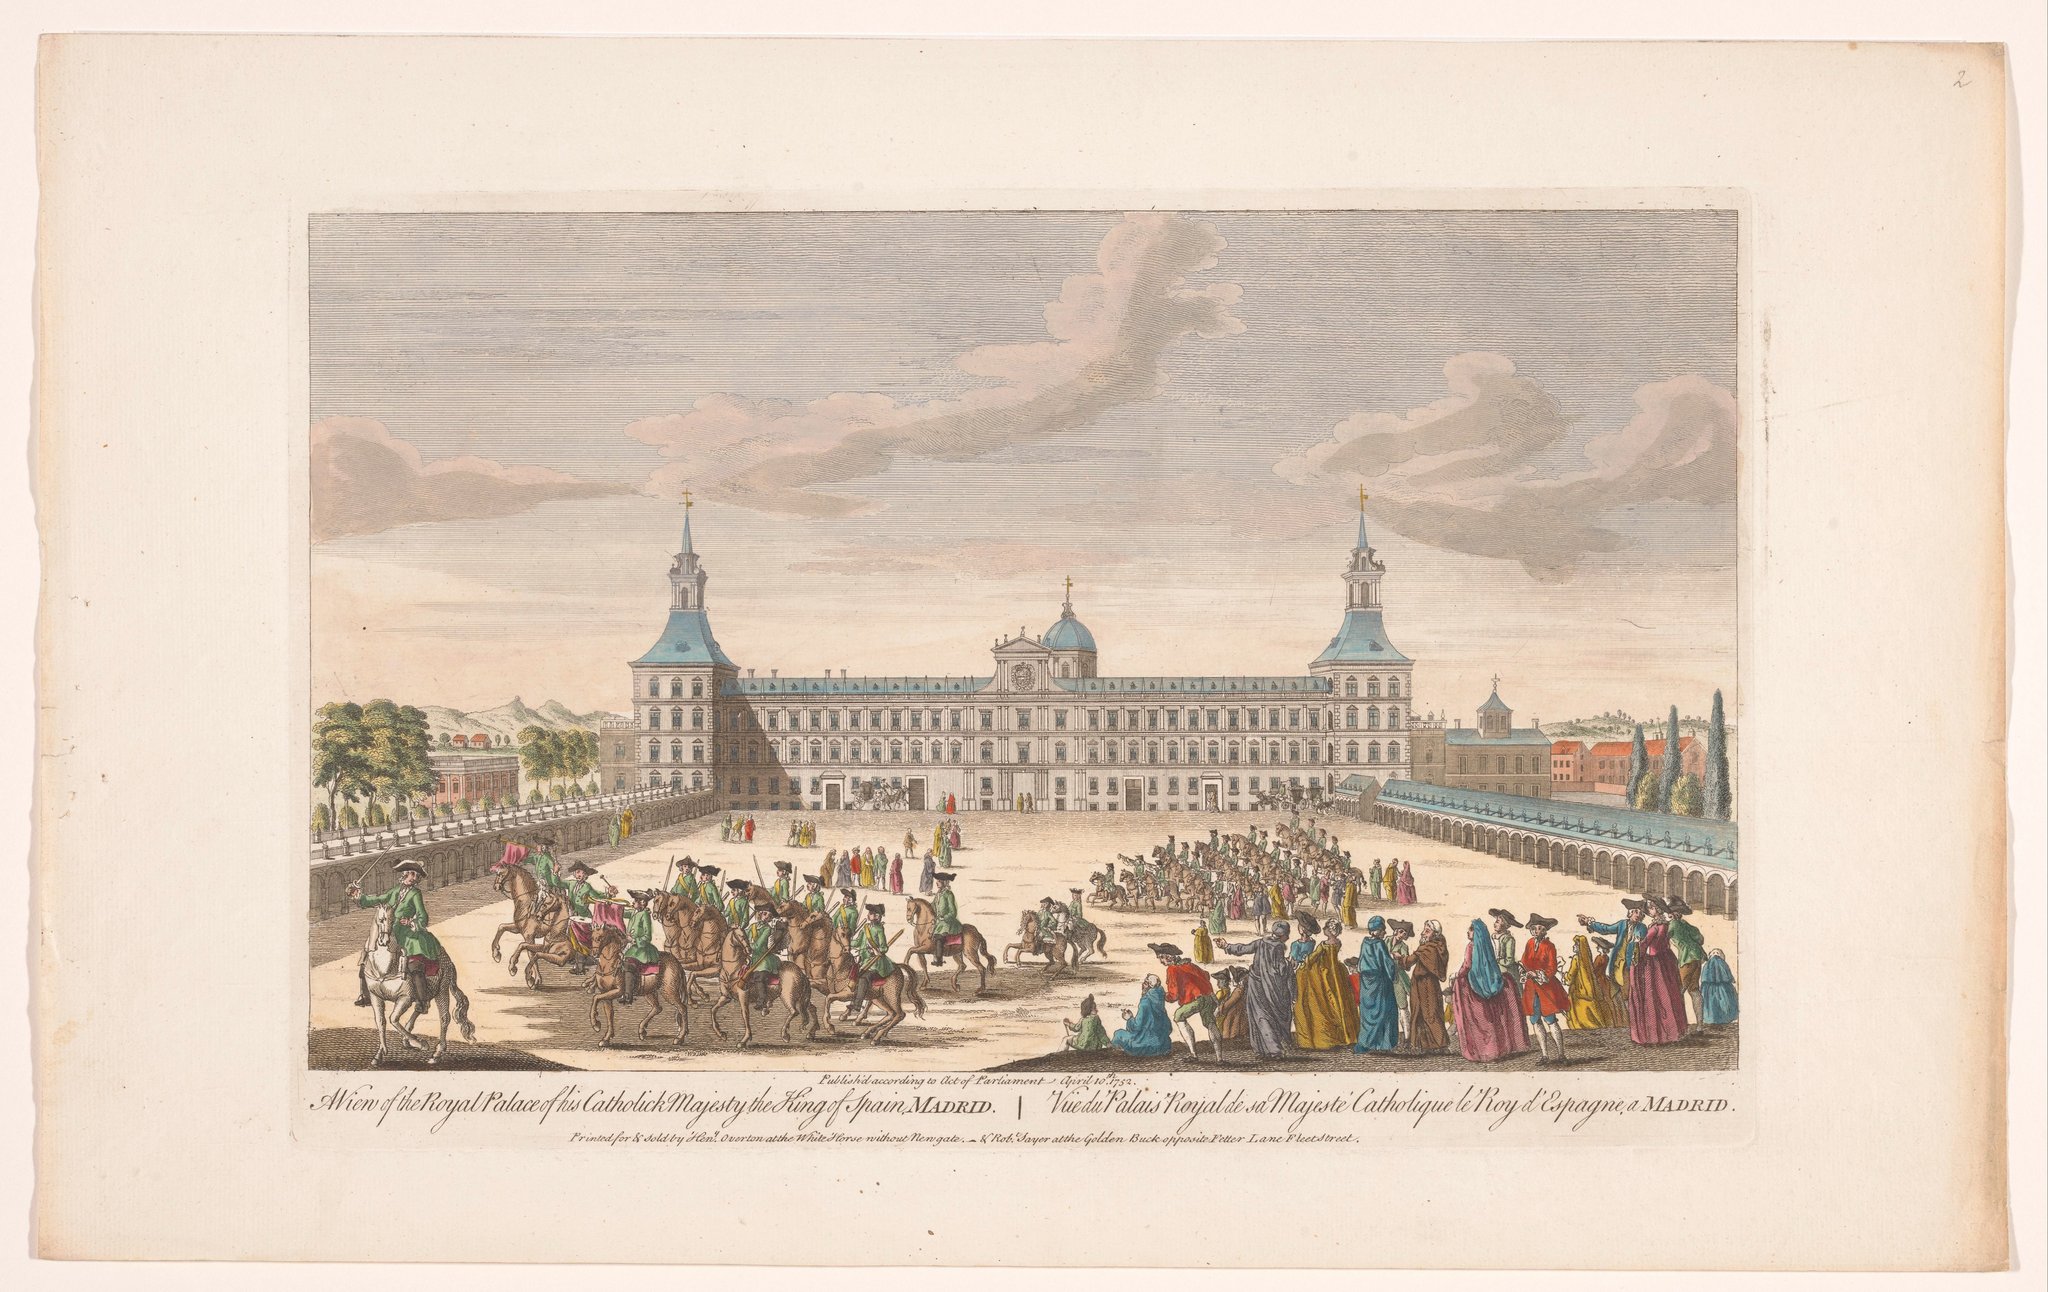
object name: print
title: A view of the Royal Palace of his catholick majesty the king of Spain, Madrid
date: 1752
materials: paper, watercolor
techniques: brush, etching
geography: london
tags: palace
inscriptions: watermark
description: De serie “Madrid en Lissabon” bevat vier prenten met de nummers 1-4, waarvan dit nummer 2 is.